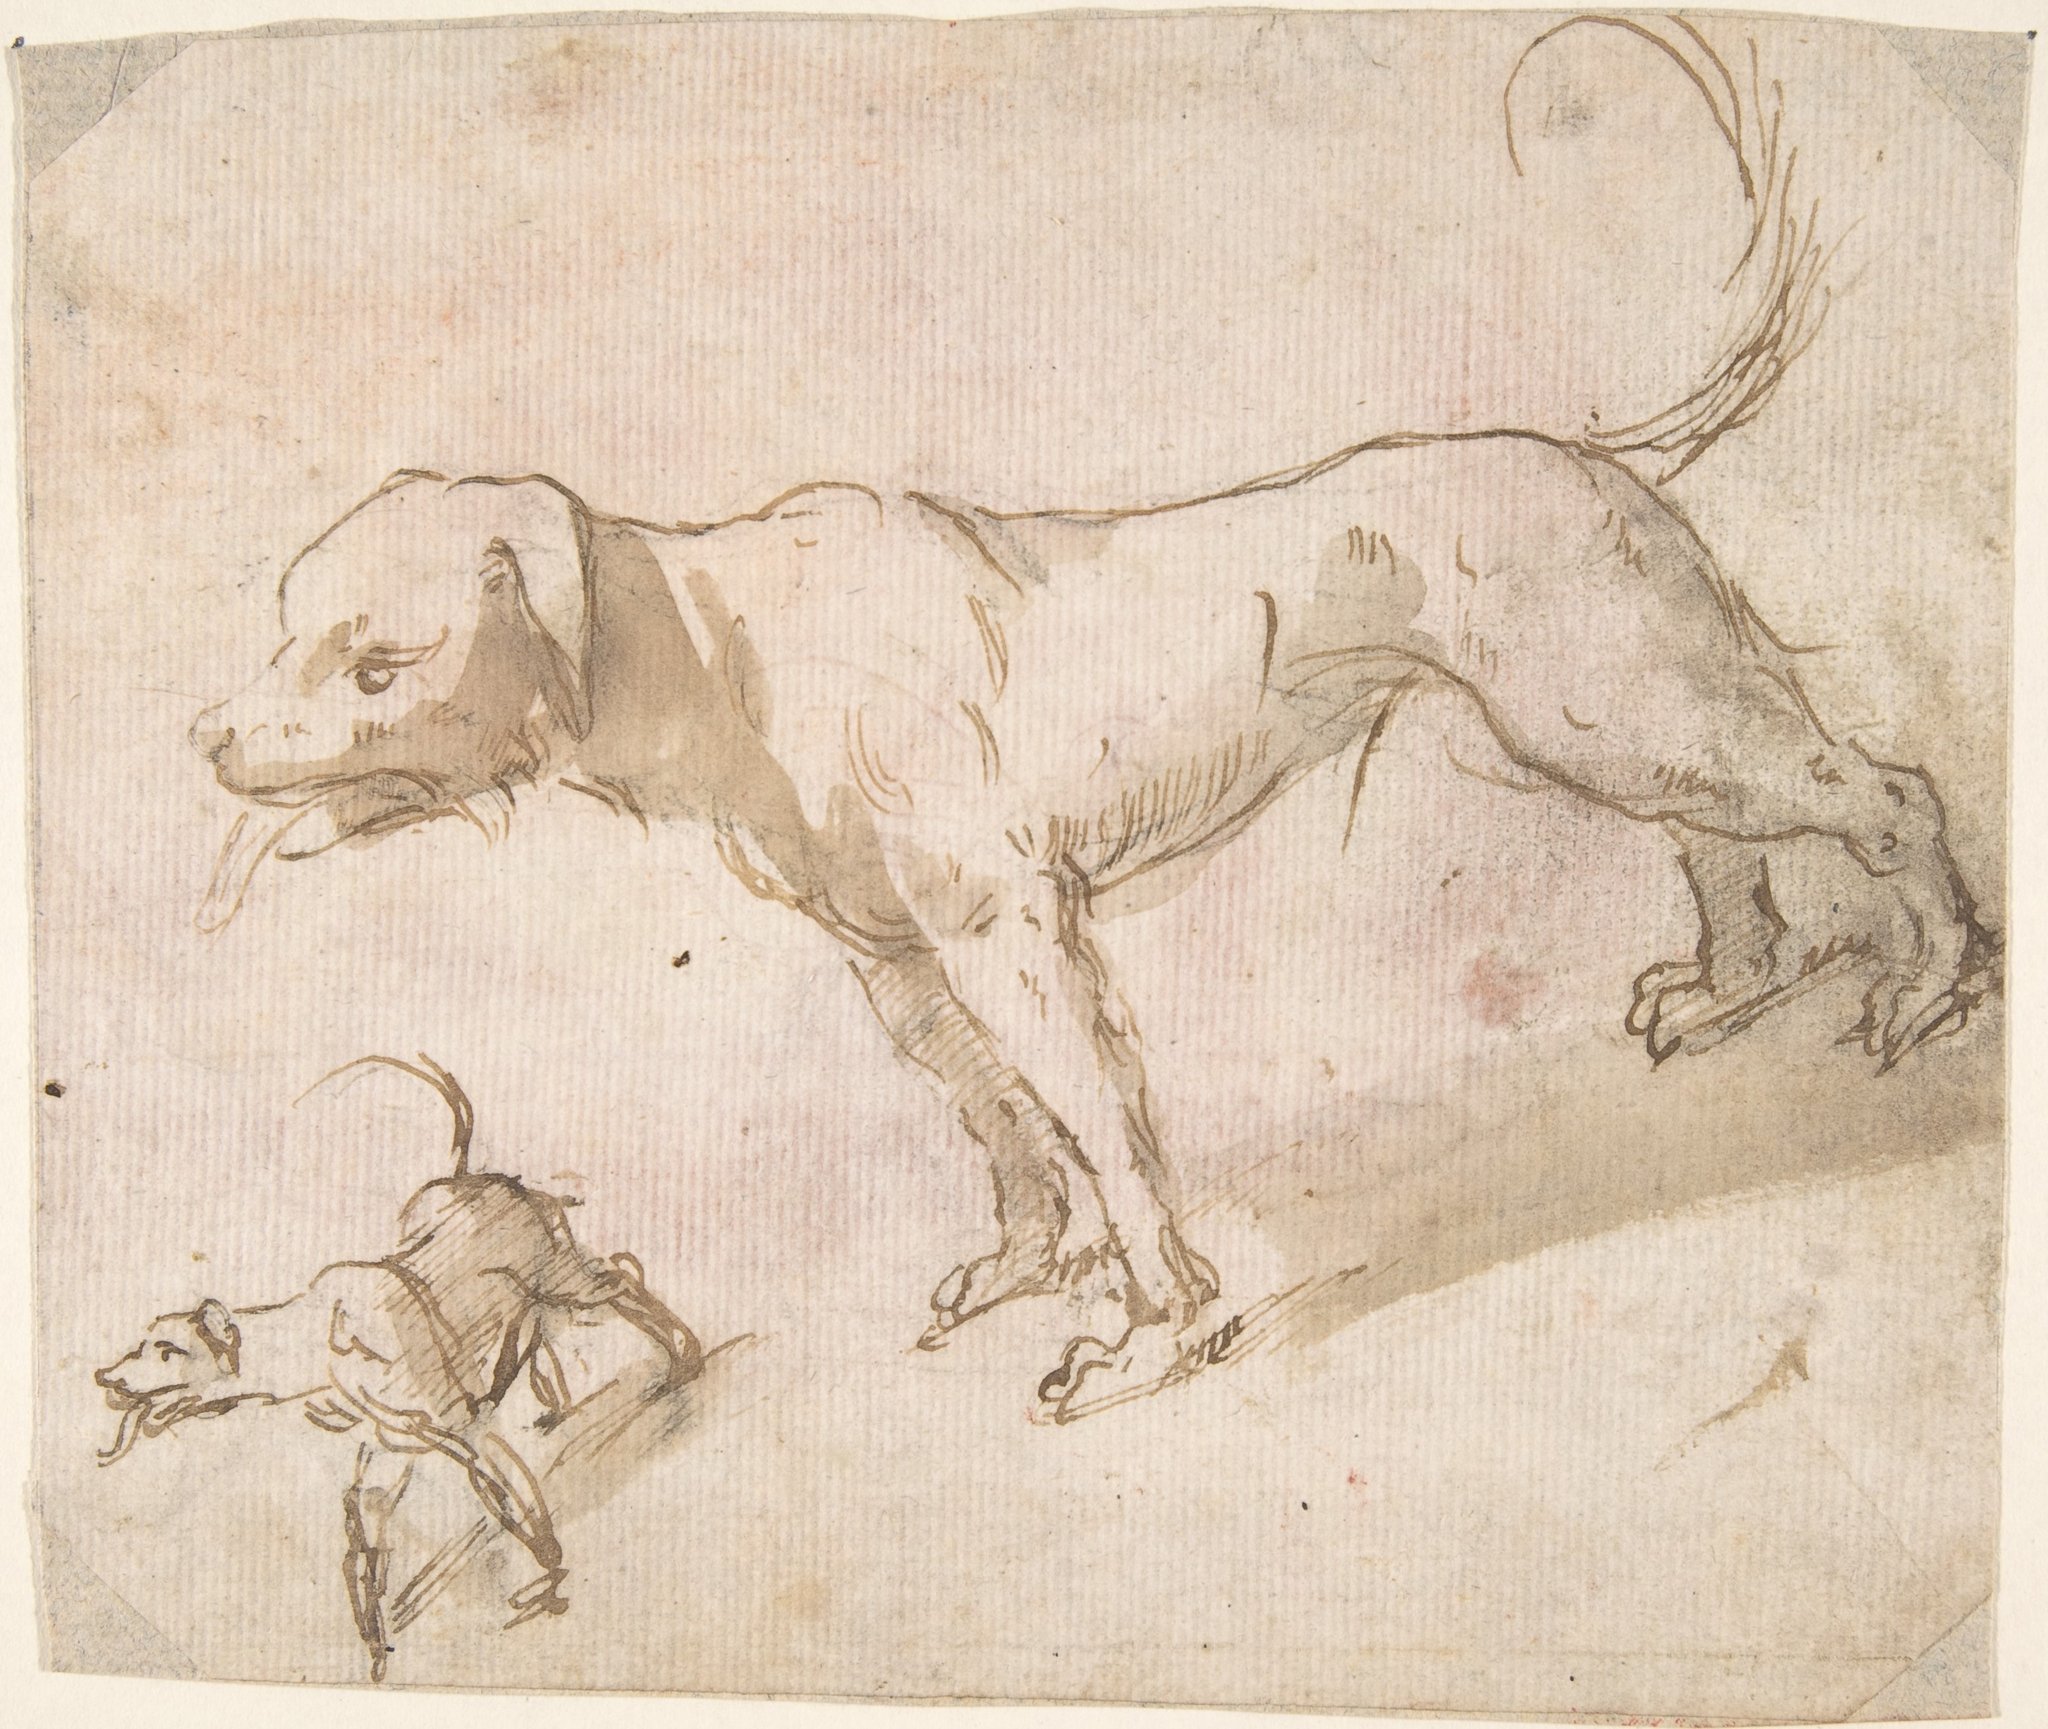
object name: drawing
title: Two Dogs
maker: anonymous, spanish, school of seville, 17th century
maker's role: artist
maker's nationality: spanish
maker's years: 1600-1700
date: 1601-1700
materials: chalk, ink, paper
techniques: brush, pen, drawing, wash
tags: dogs